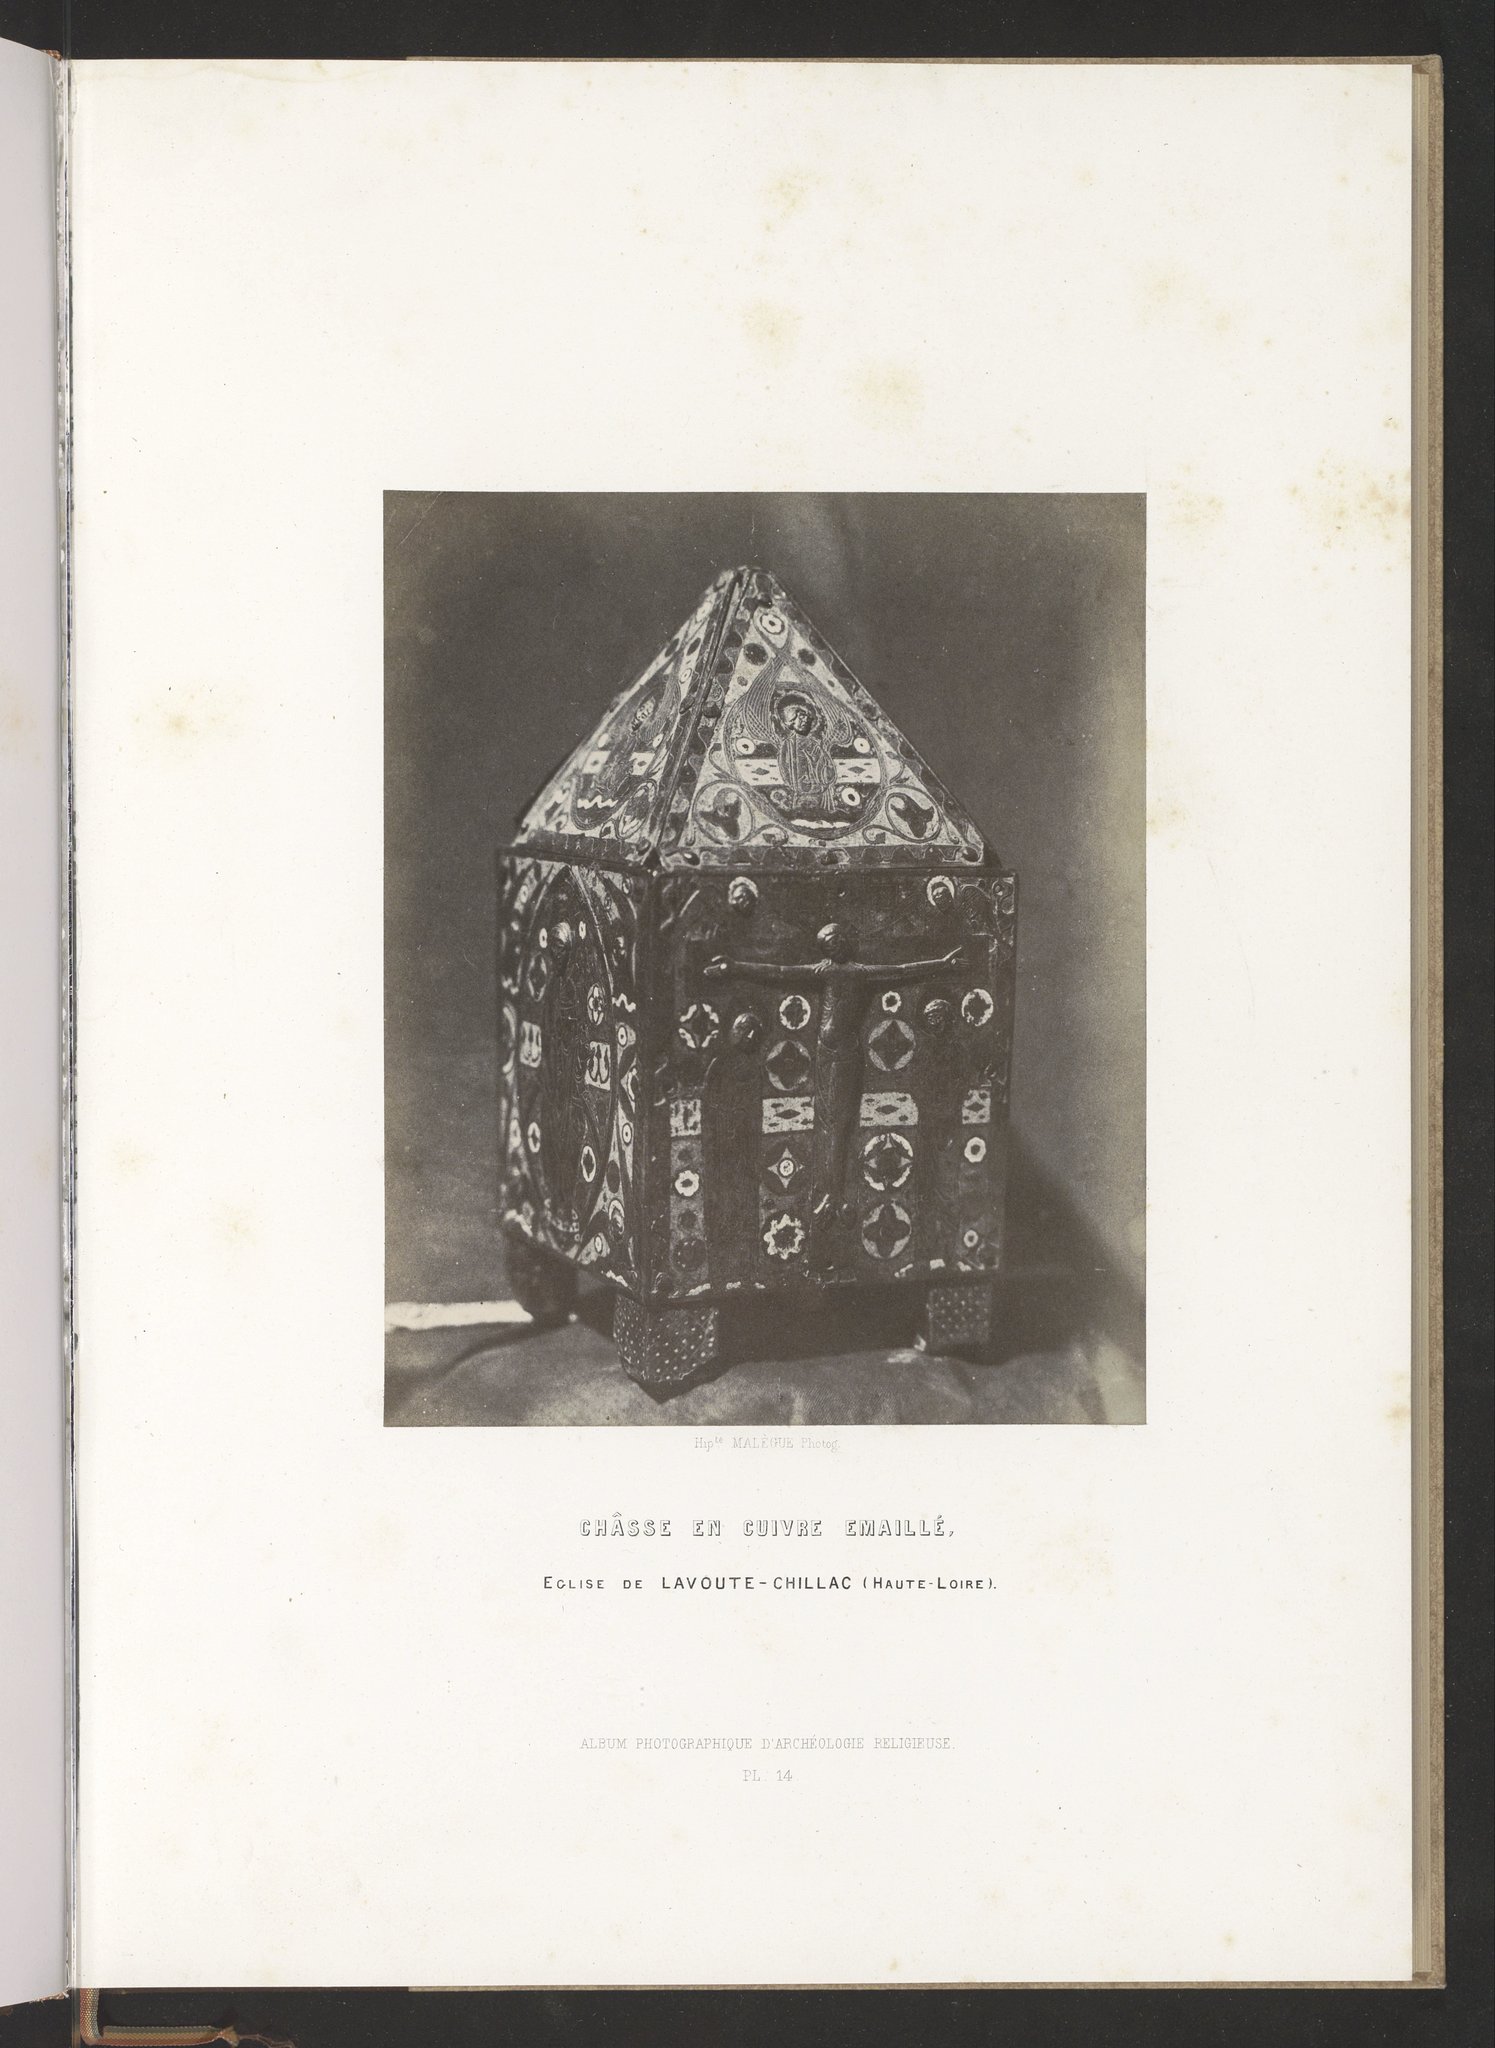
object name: photograph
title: Reliekschrijn afkomstig van Lavoûte-Chilhac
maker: hippolyte malègue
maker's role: archeoloog, fotograaf, schrijver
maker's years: 1825-1901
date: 1850-1857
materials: photographic support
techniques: salted paper print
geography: france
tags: relics (and reliquaries)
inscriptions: number: ‘PL. 14.’, inscription: ‘eglise de Lavoute-Chillac (Haute-Loire).’